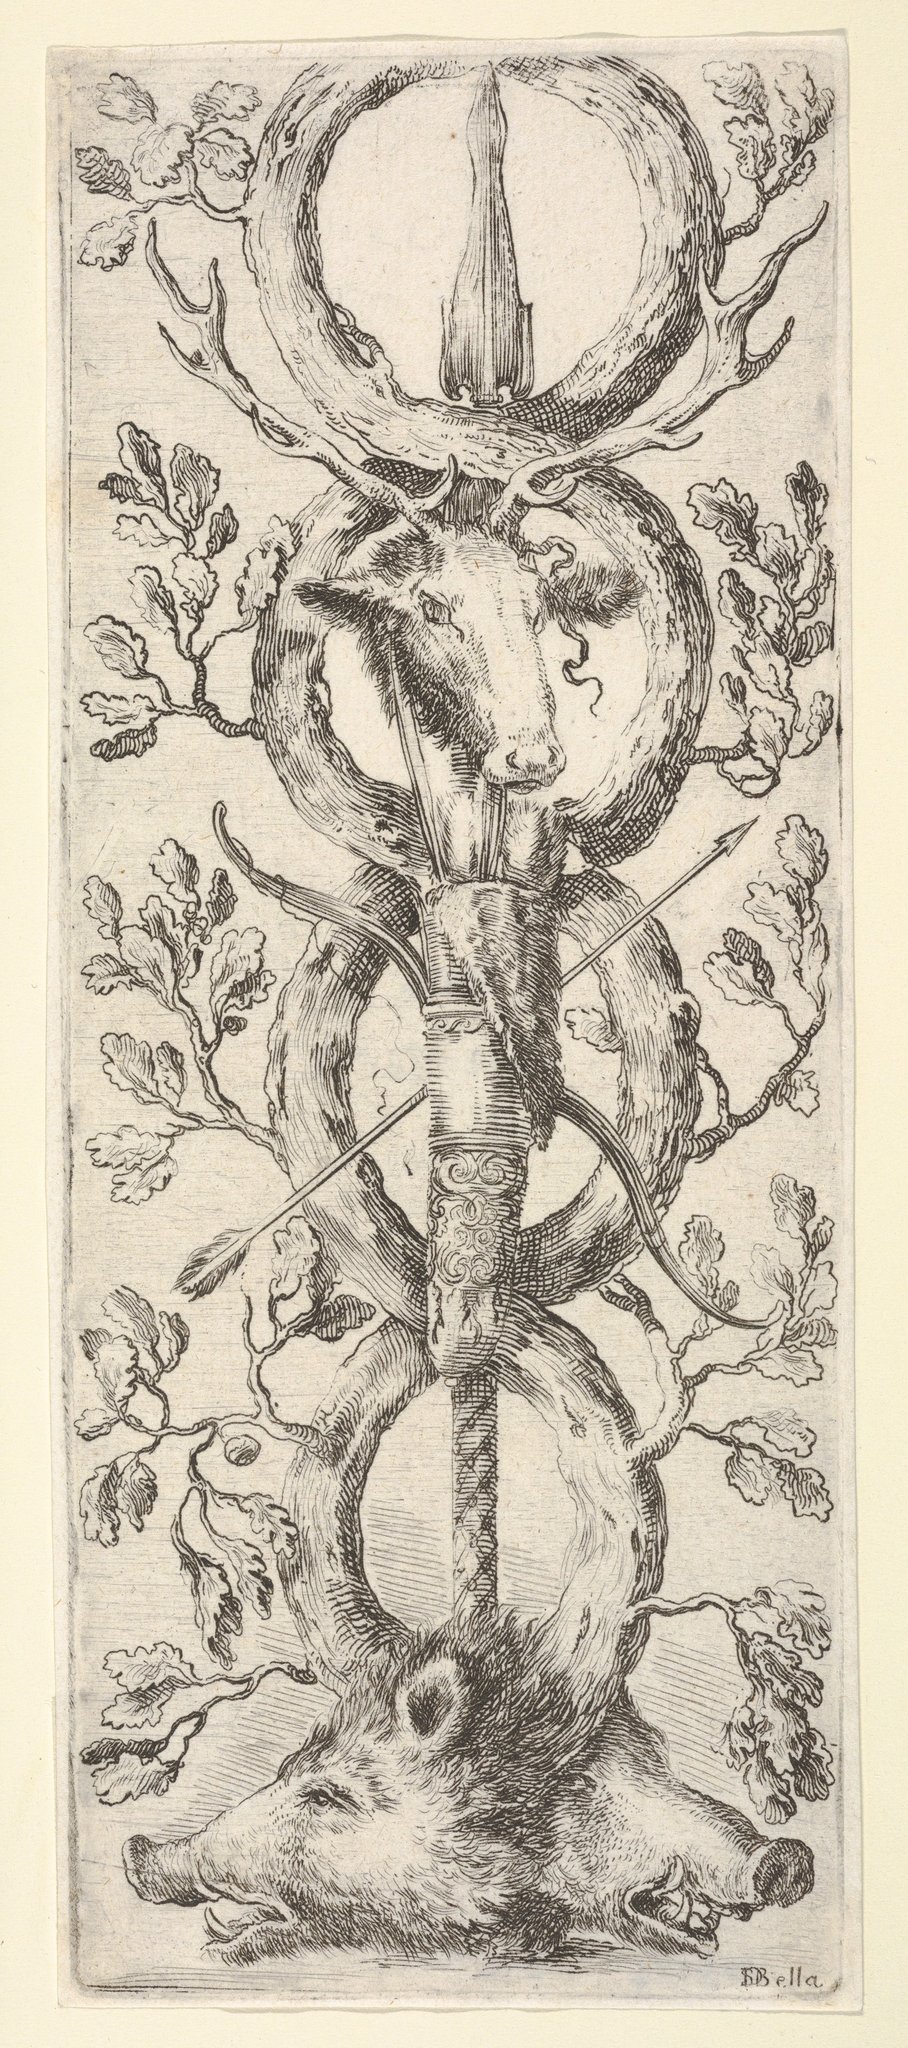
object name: print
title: Two wild boar heads below, a deer head above, a bow and arrow in center, from "Ornaments or Grotesques" (Ornamenti o Grottesche)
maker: stefano della bella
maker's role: artist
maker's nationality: italian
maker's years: 1610-1664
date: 1650-1656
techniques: etching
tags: bow and arrow,boars,deer